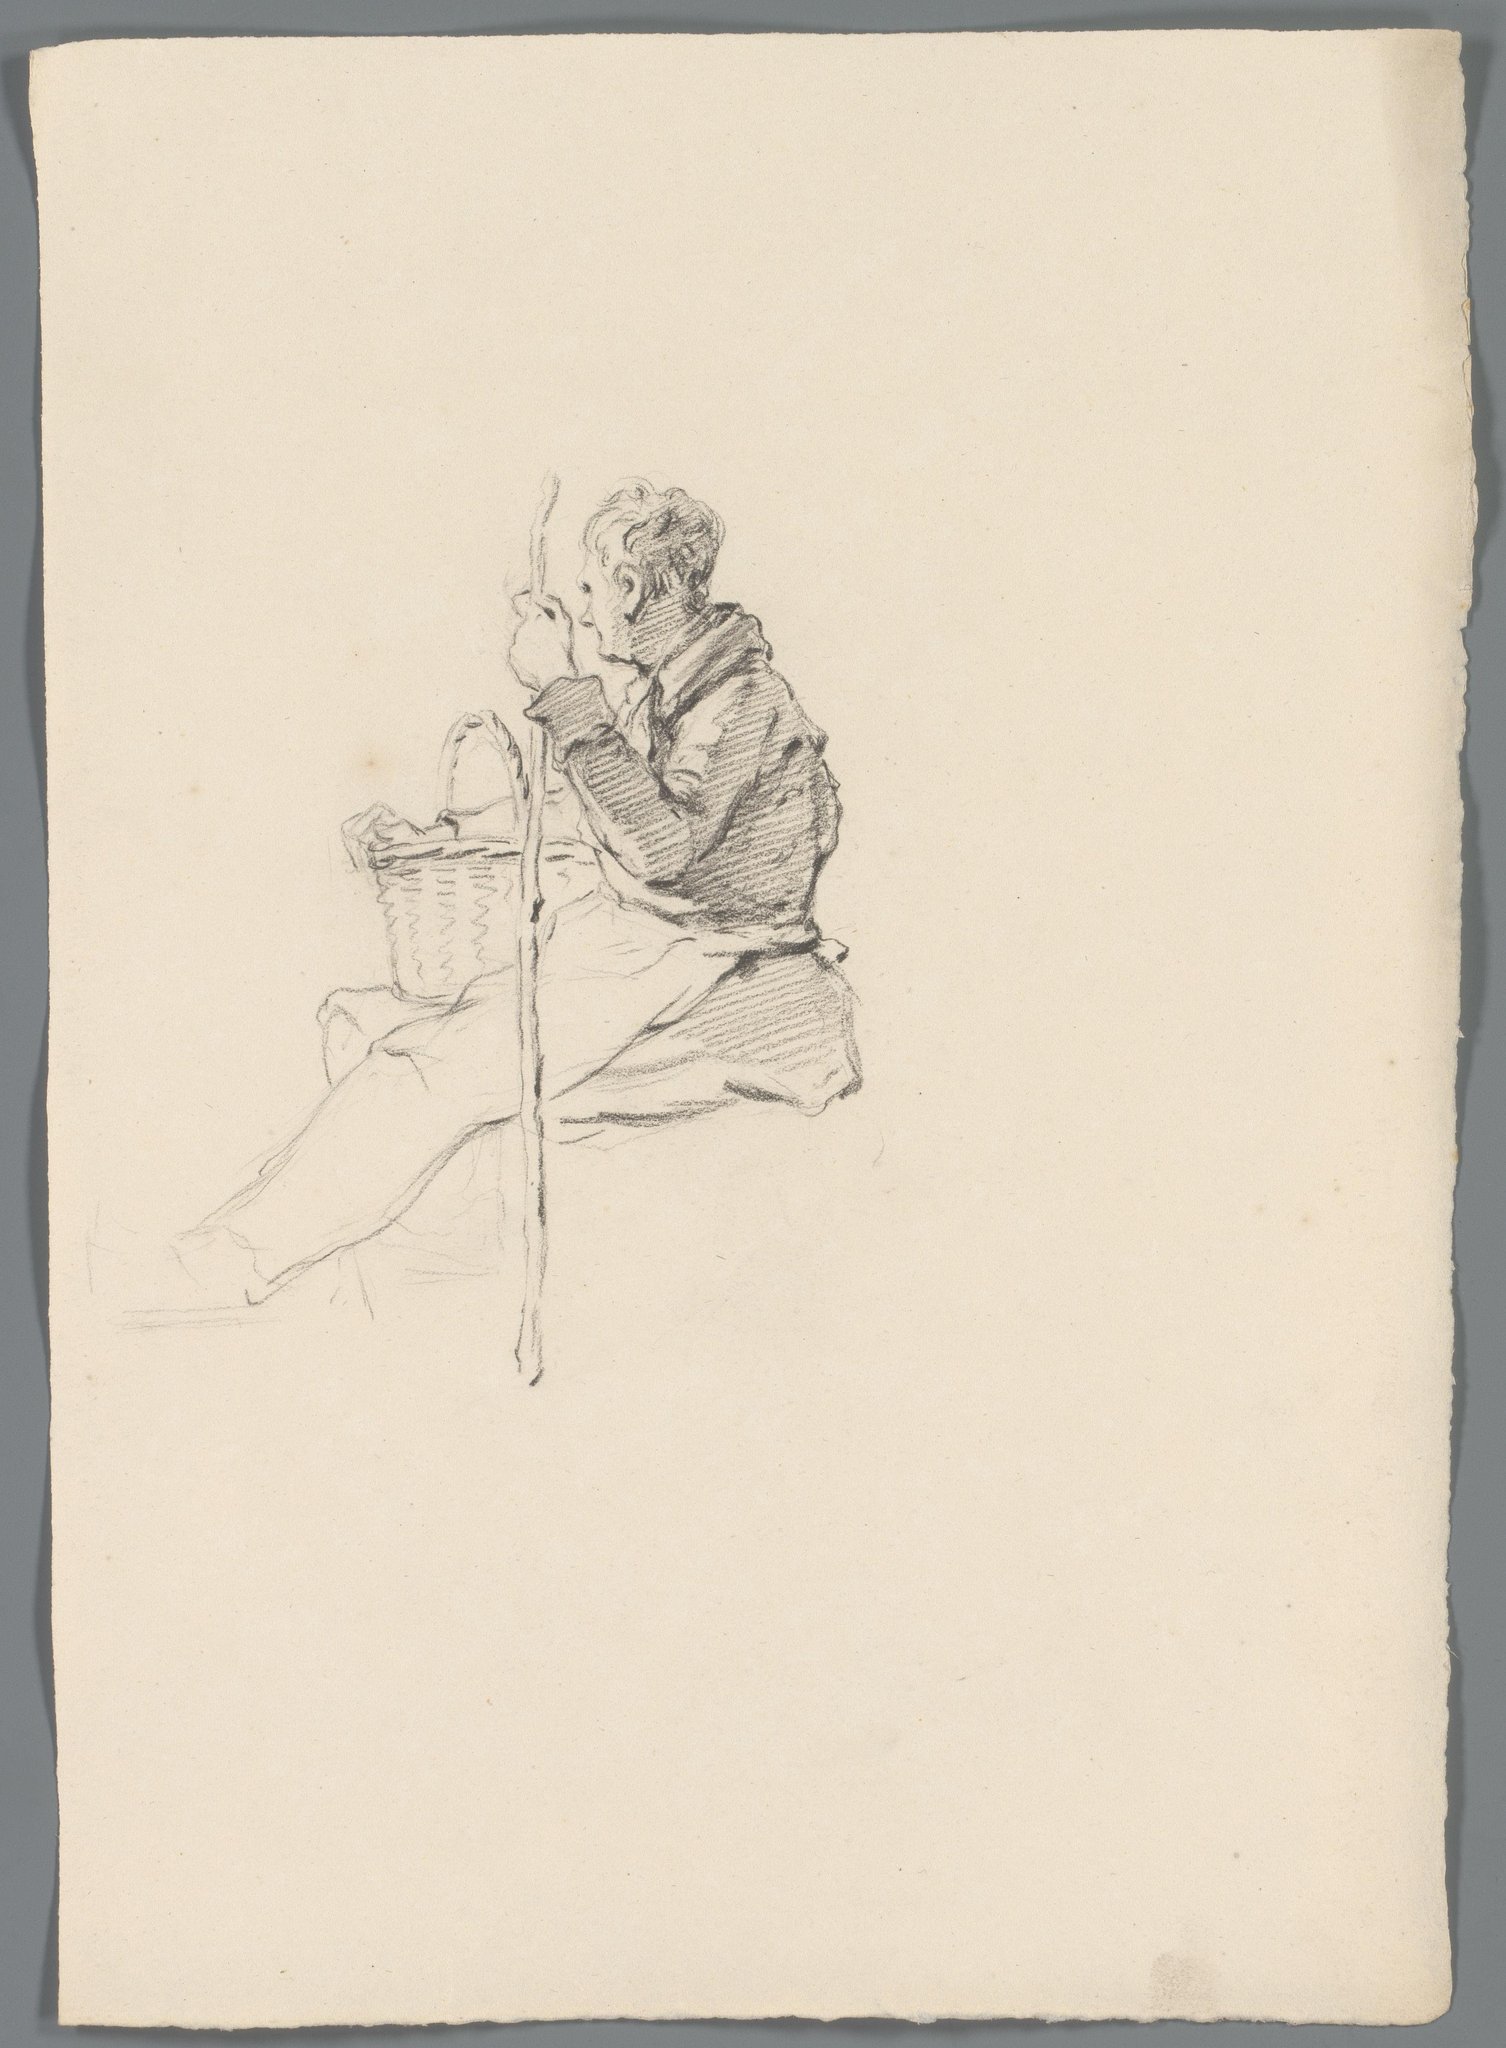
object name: drawing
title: Zittende man met mand en wandelstok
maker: Anonymous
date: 1820-1830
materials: chalk, paper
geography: the hague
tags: sitting figure, walking-stick, staff, adult man, container made of plant material other than wood: basket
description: Tekeningen waarschijnlijk ontstaan bij het Haagse kunstgenootschap ‘Tot Nut der Tekenkunst’, waar twee keer per week tekenavonden werden georganiseerd met geklede modellen.